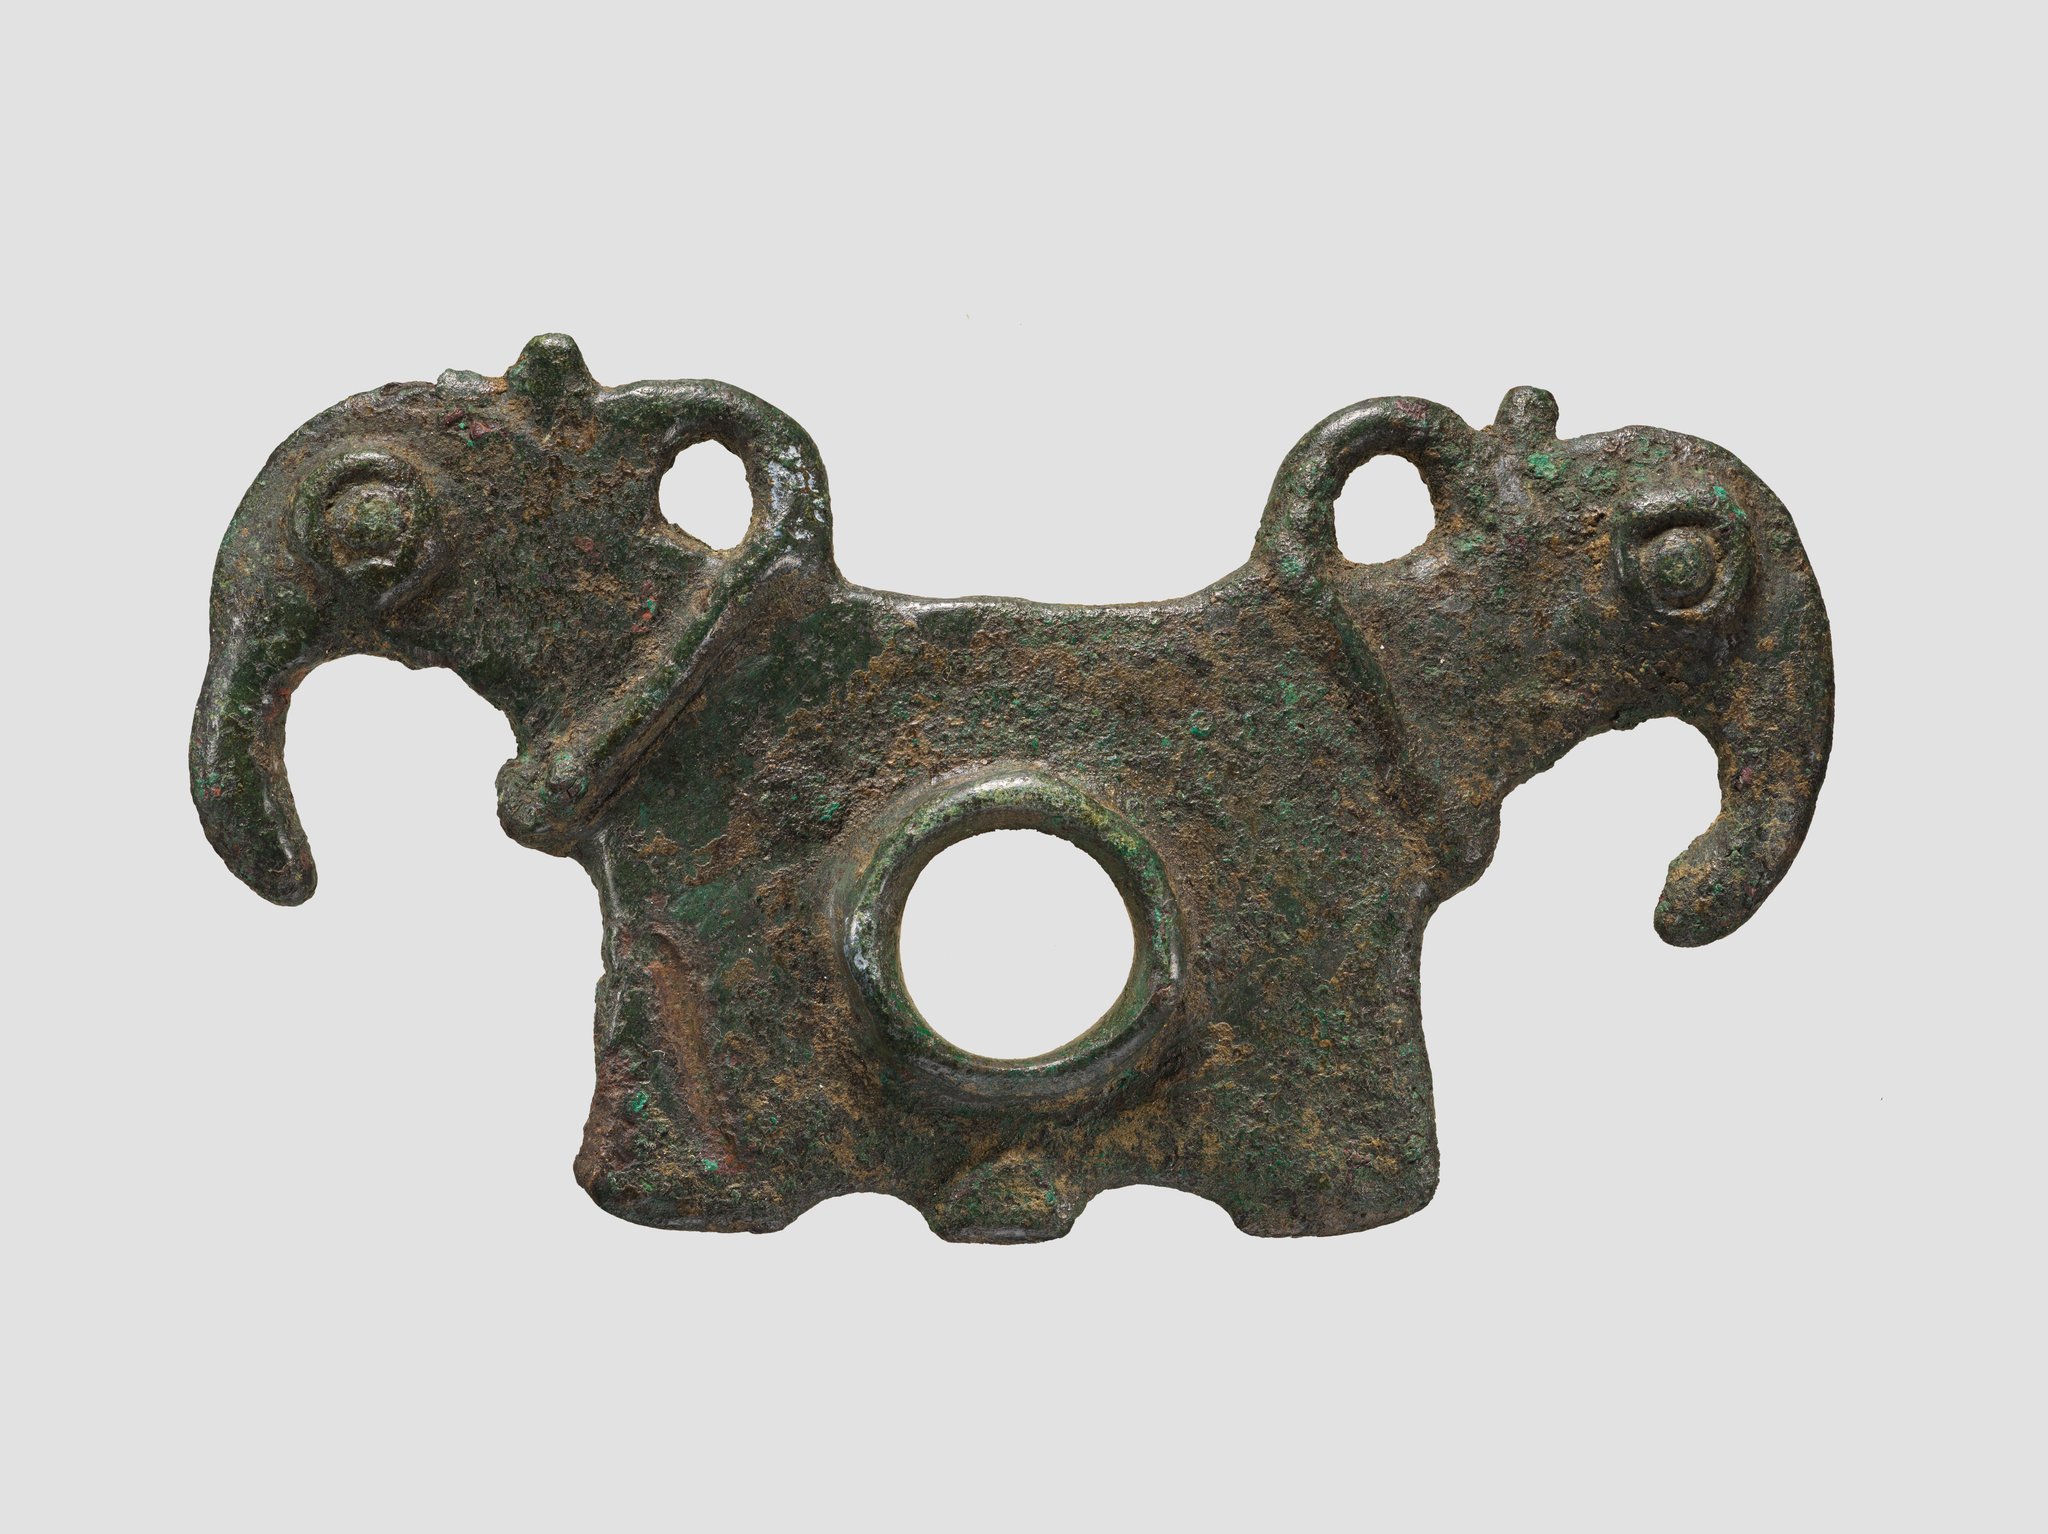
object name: horse bit cheekpiece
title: Horse bit cheekpiece in form of addorsed bird heads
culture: iranian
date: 800-601 BCE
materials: bronze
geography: western iran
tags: birds